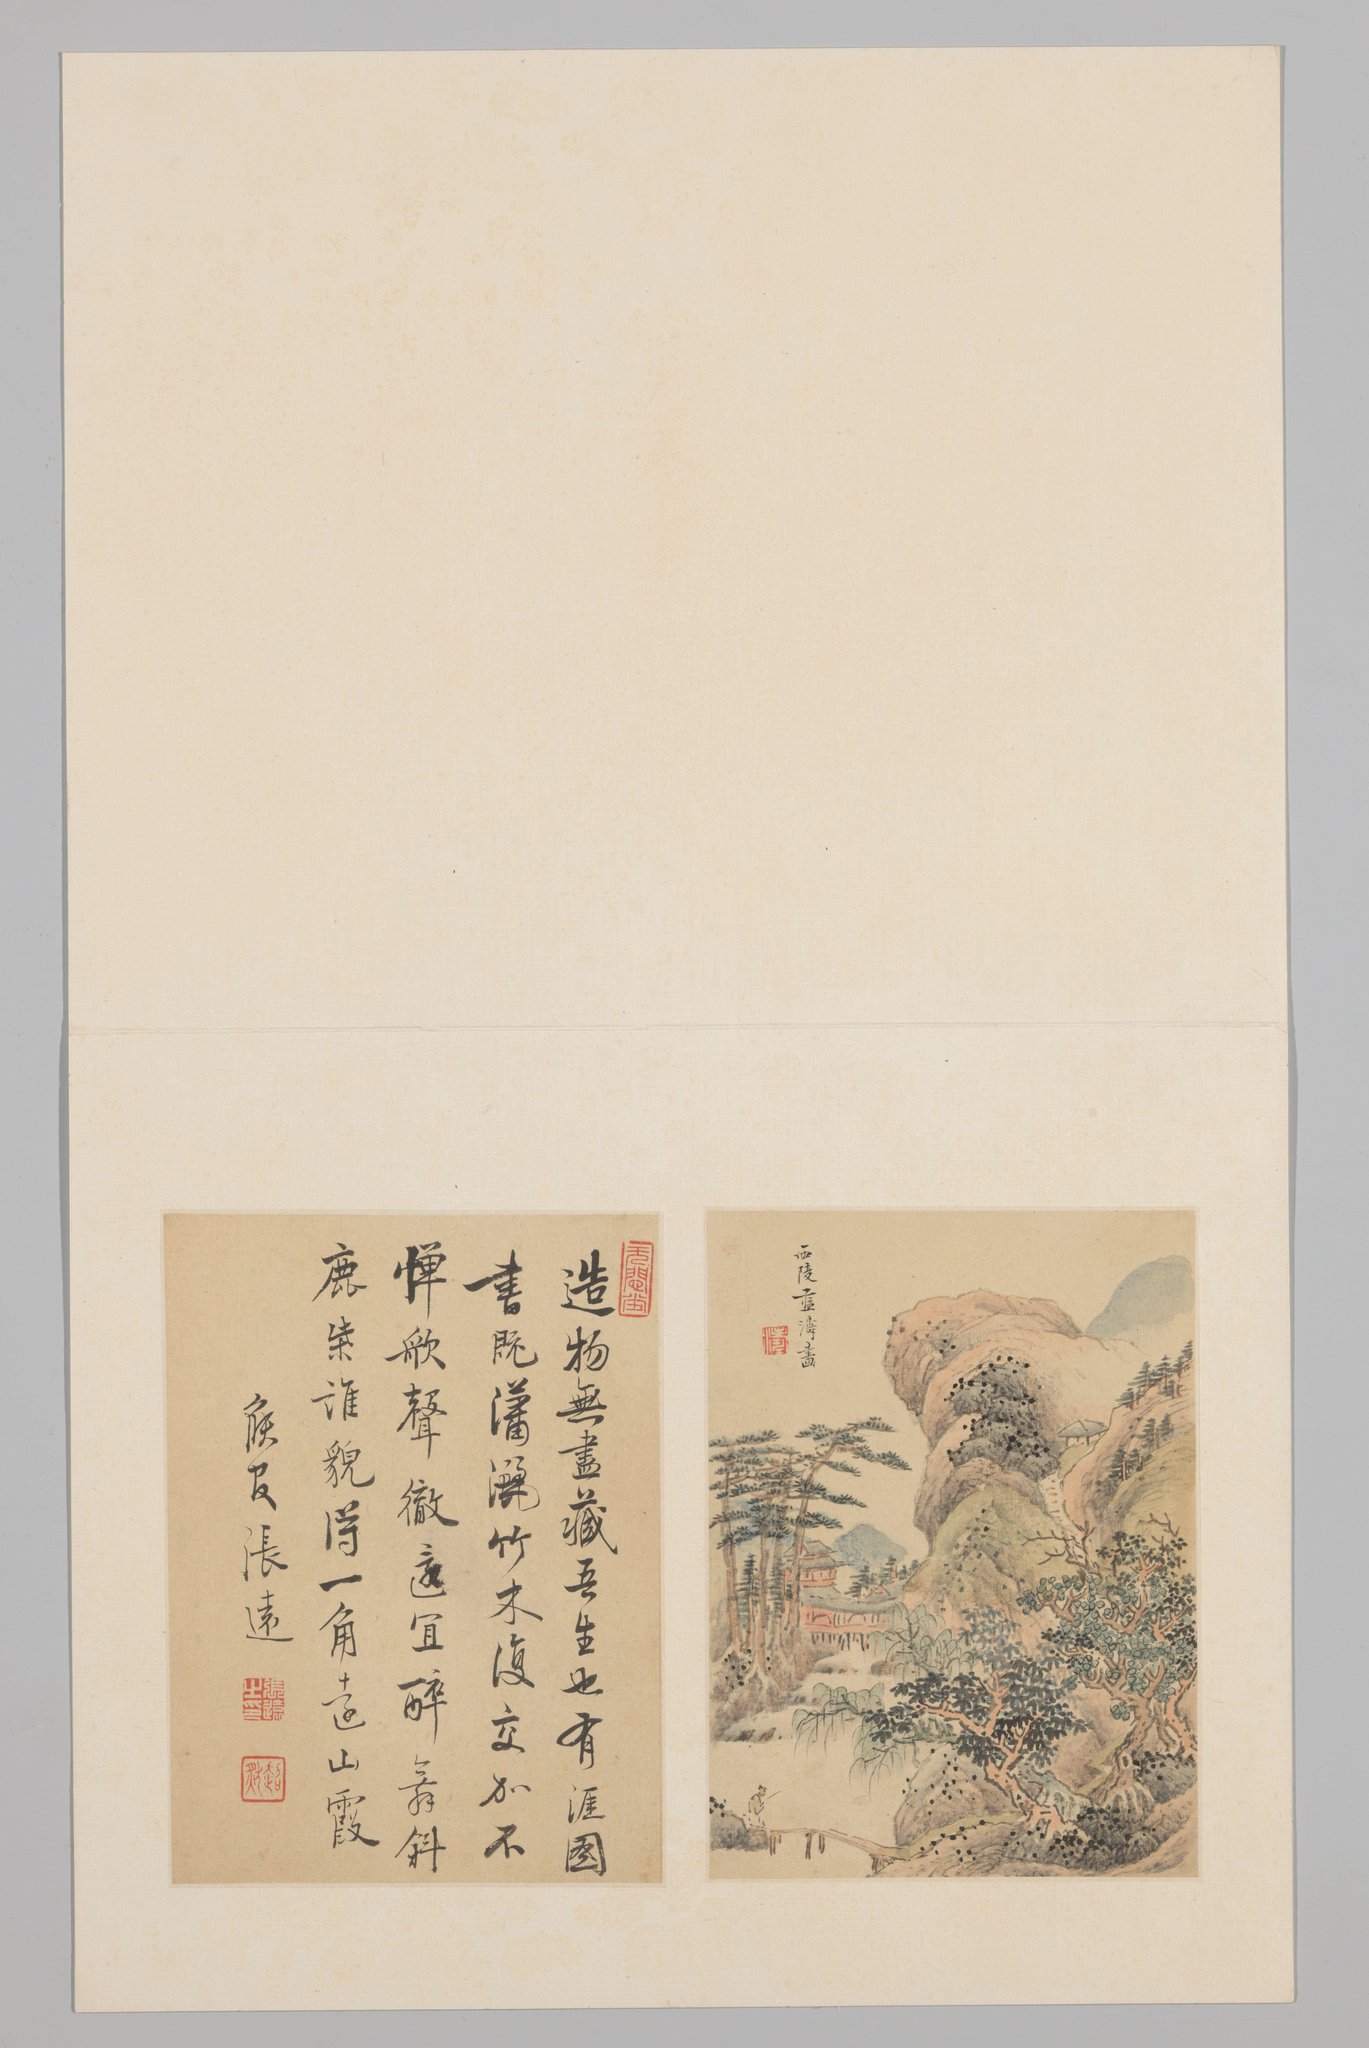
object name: album leaf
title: Albumblad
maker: lan tao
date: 1675-1700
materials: ink, paper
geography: hangzhou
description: Landscape with calligraphy by Zhang Yuan Lan Tao. China. C. 1700. Ink and colours on paper. This album page was painted by Lan Tao, one of the so-called literati painters, amateur artists with a literary background. Literati painters often referred in their work to other painters or to poetry. In addition to the painting of an angler in the foreground the page includes a poem in calligraphic characters: Creation is an inexhaustible storage room. But our lives are limited. The painting is light of touch. Yet the bamboo and trees form dense brushwood. I do not fear the sound of my song, Yes, I will dance drunk until I fall. Who could show the Deer Park? Evening red over faraway mountains. Zhang Yuan of Houguan.